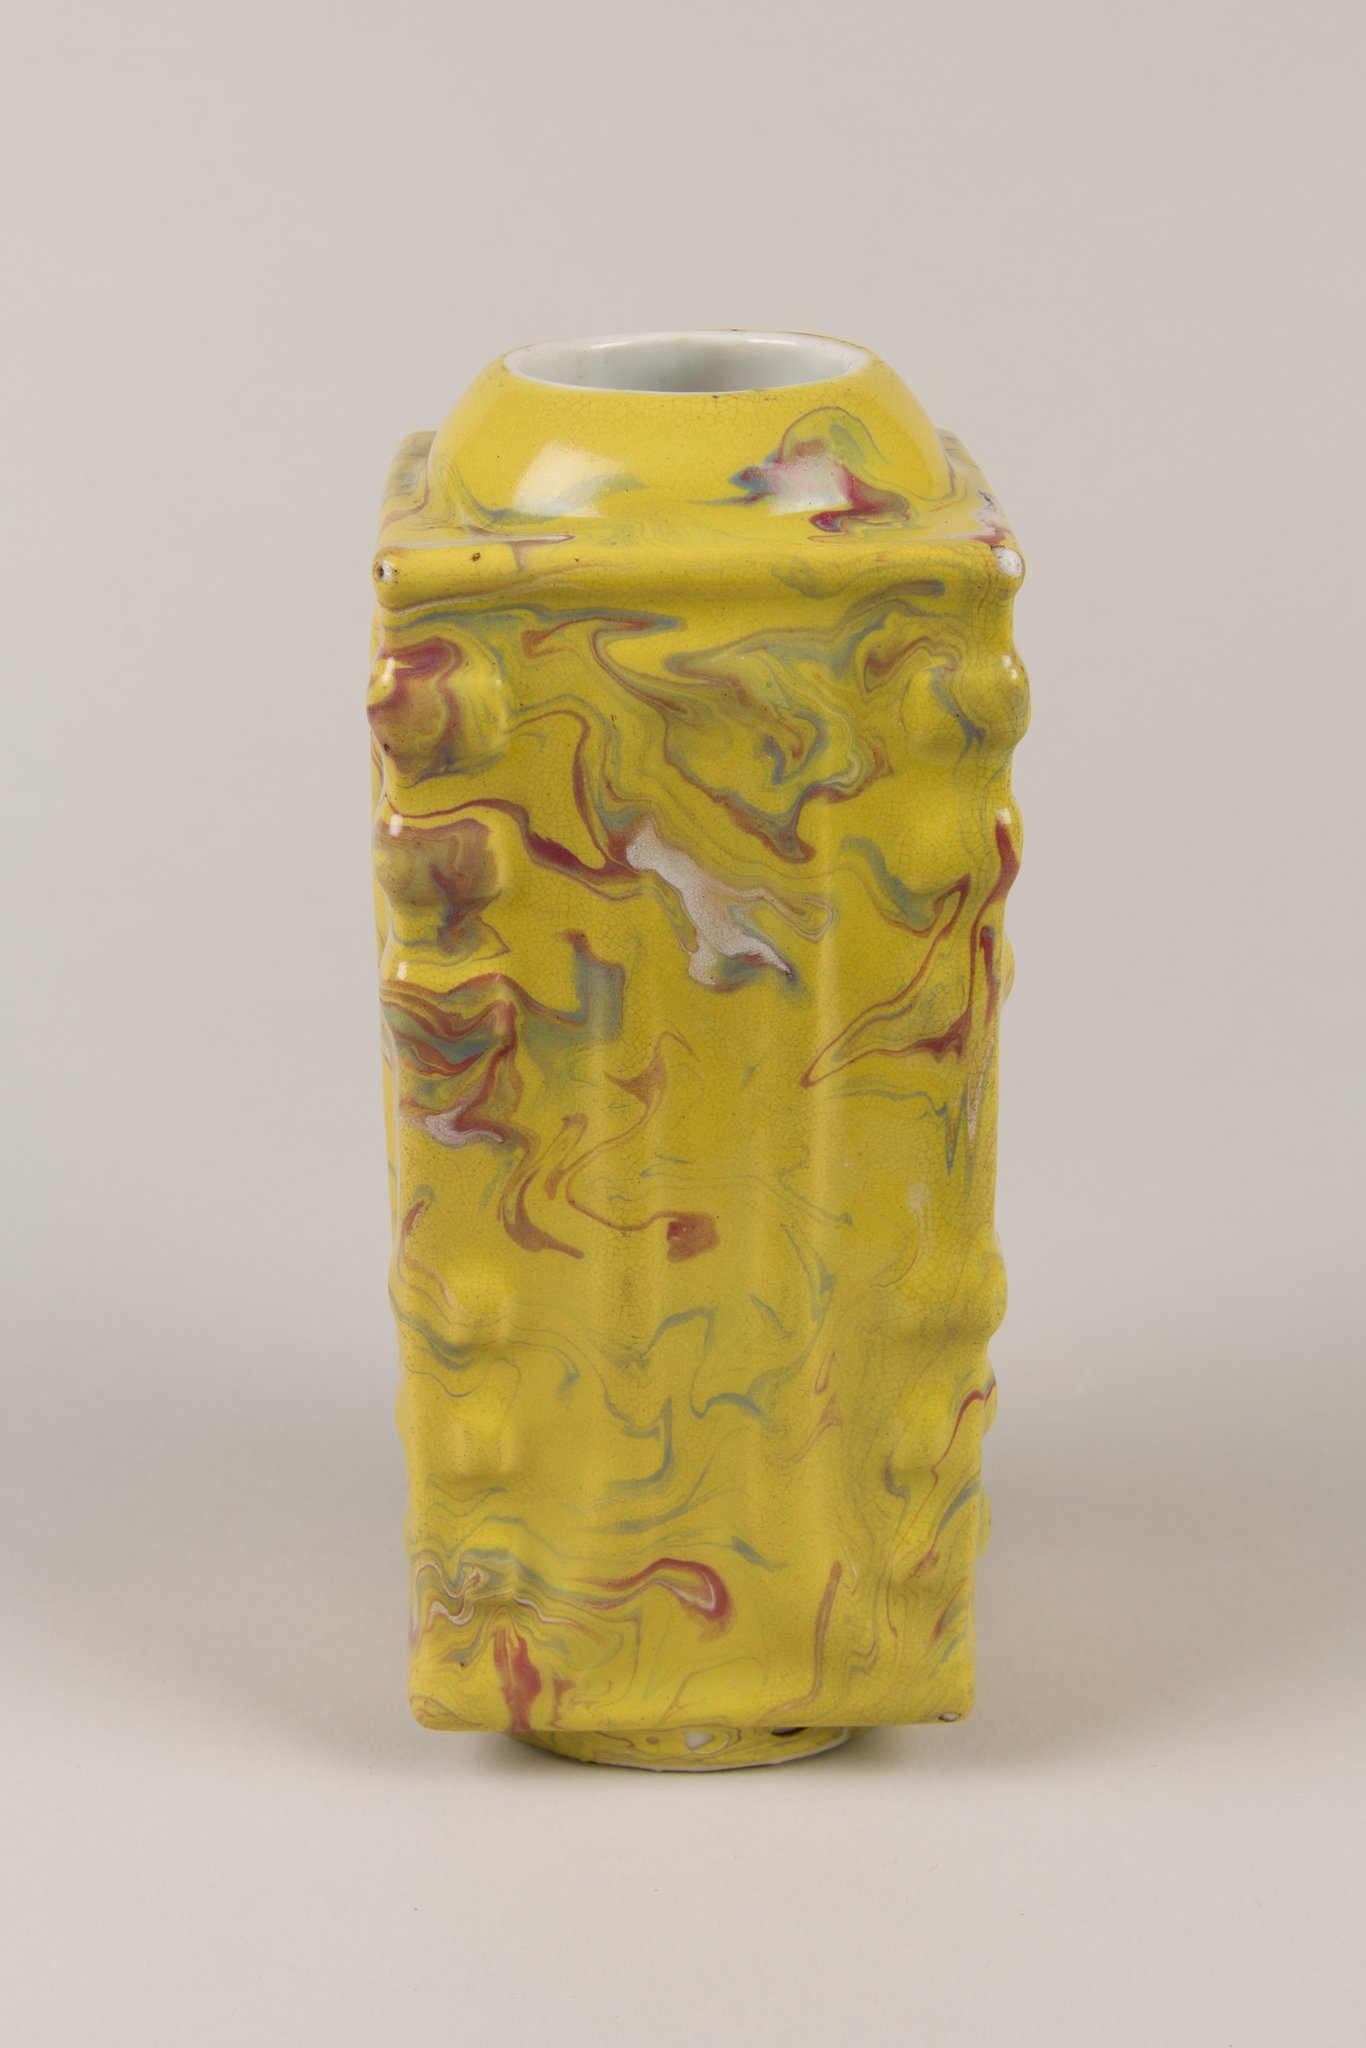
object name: vase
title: Square Vase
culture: chinese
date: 1801-1850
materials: glaze, marble, porcelain